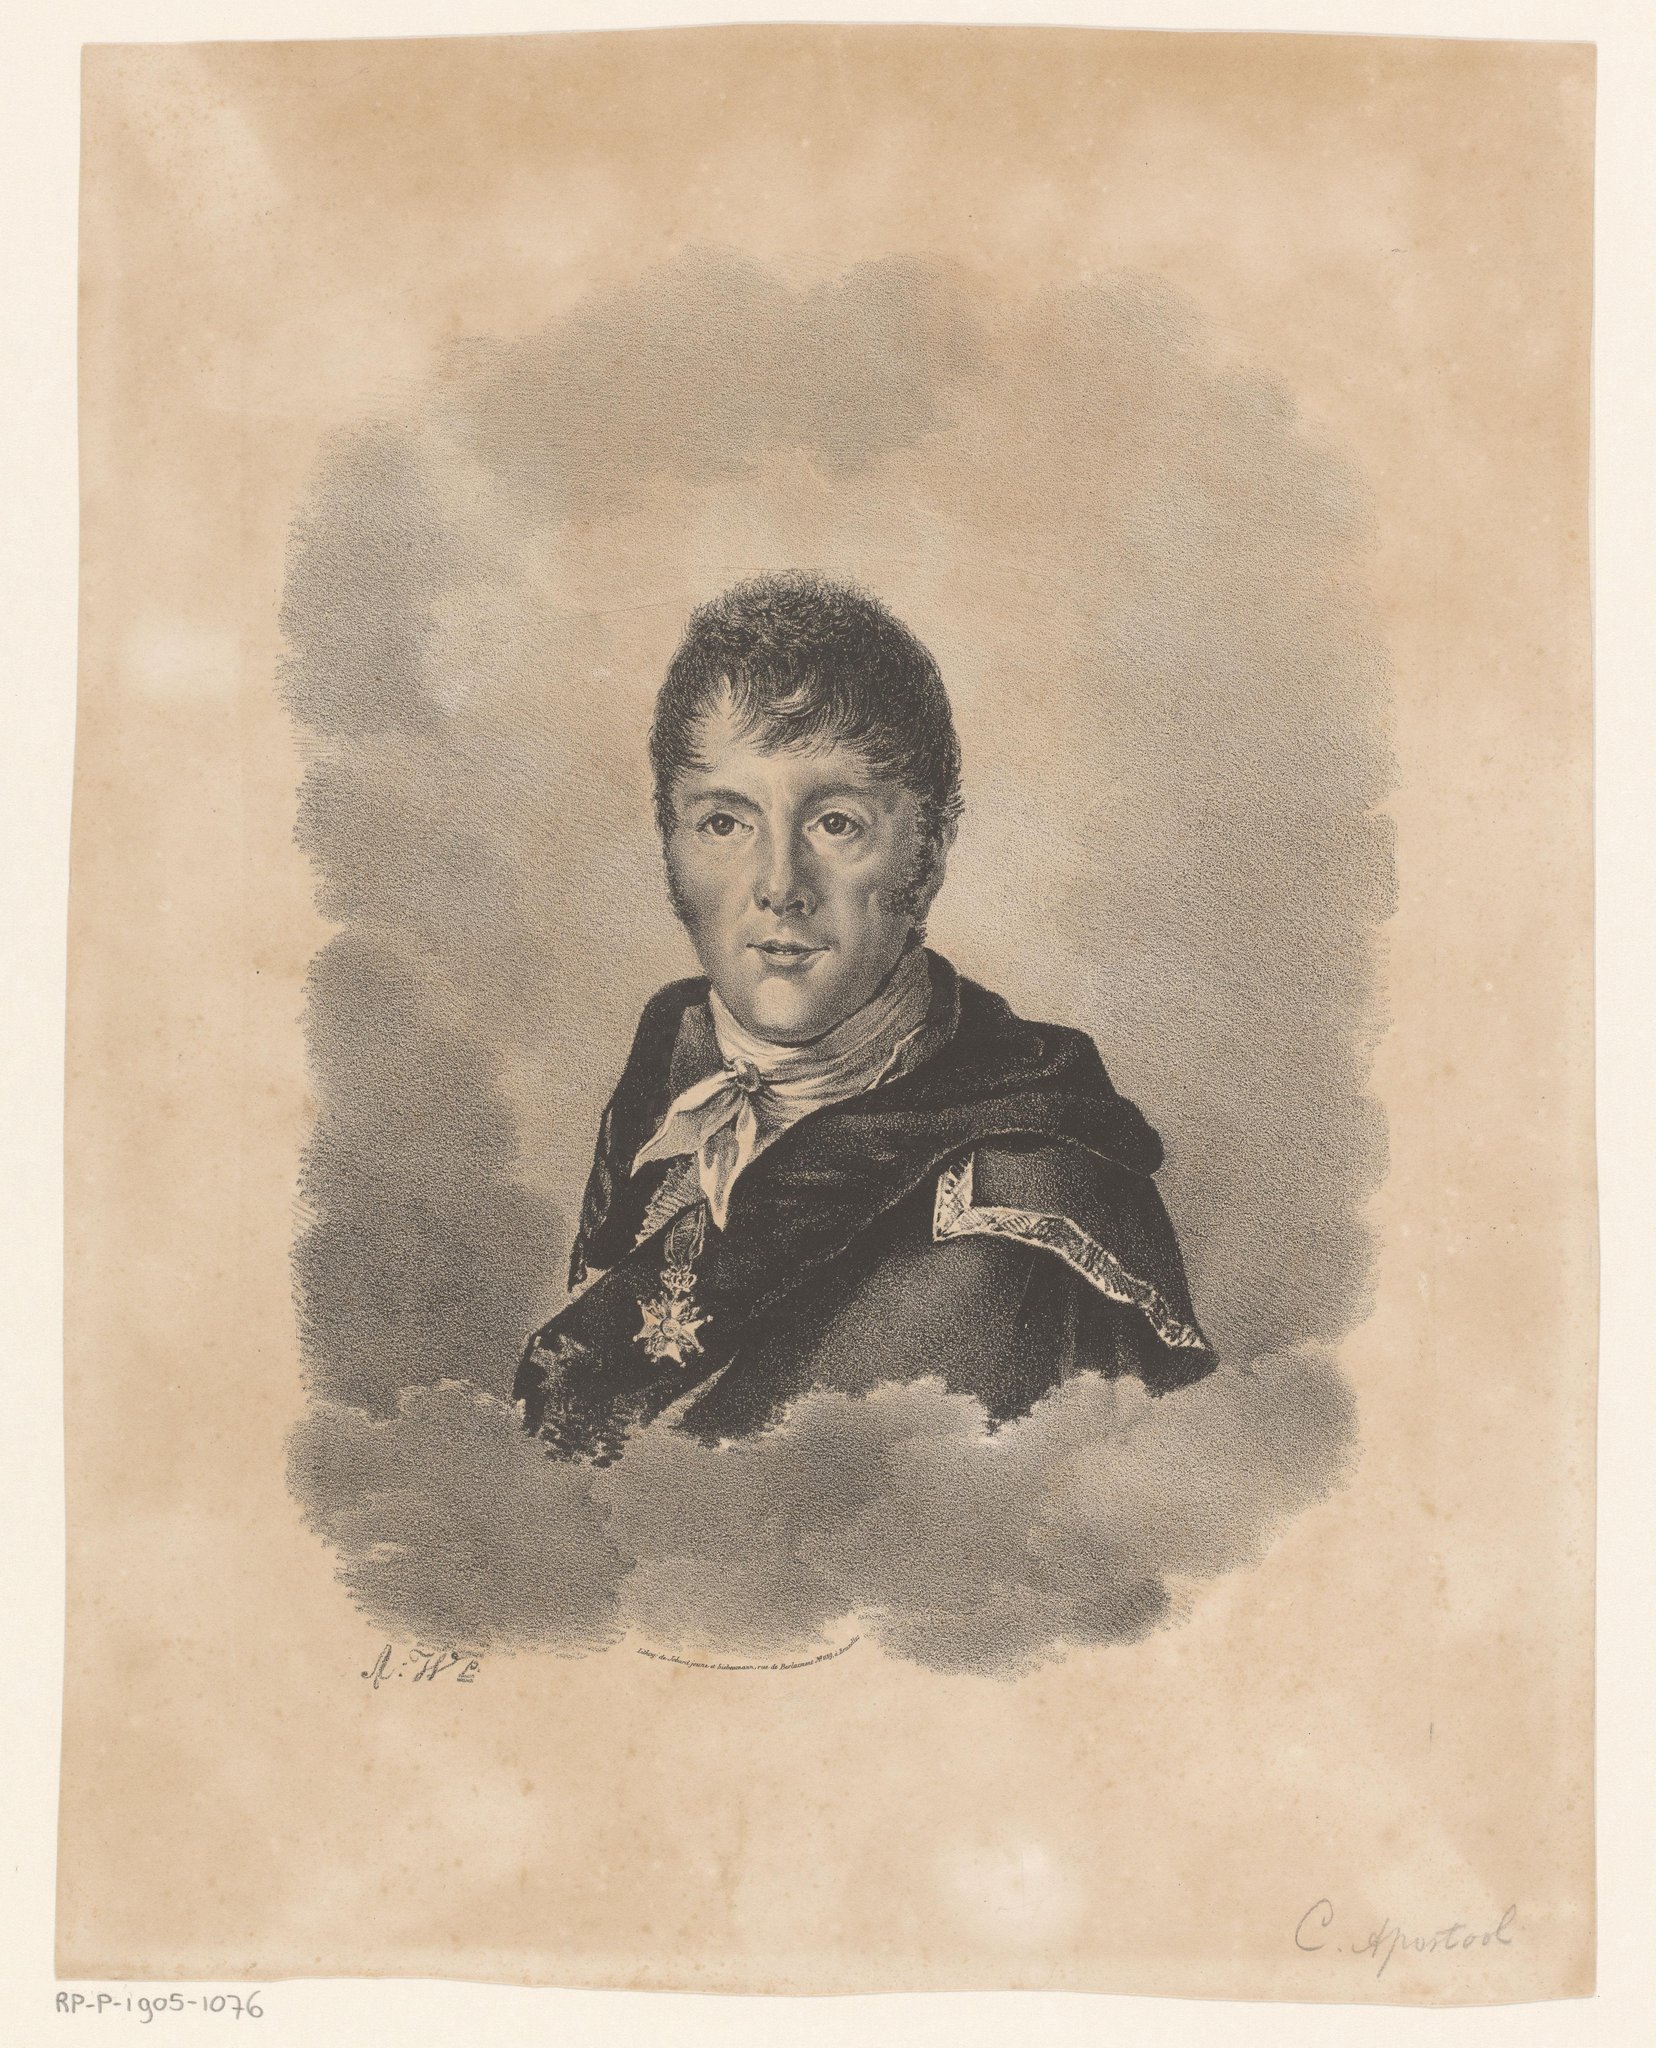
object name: print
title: Portret van Cornelis Apostool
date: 1826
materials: paper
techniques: lithograph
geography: brussels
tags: amsterdam, print maker, draughtsman, cornelis apostool, historical persons, portrait, self-portrait of painter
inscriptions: collector's mark: Lugt 2228